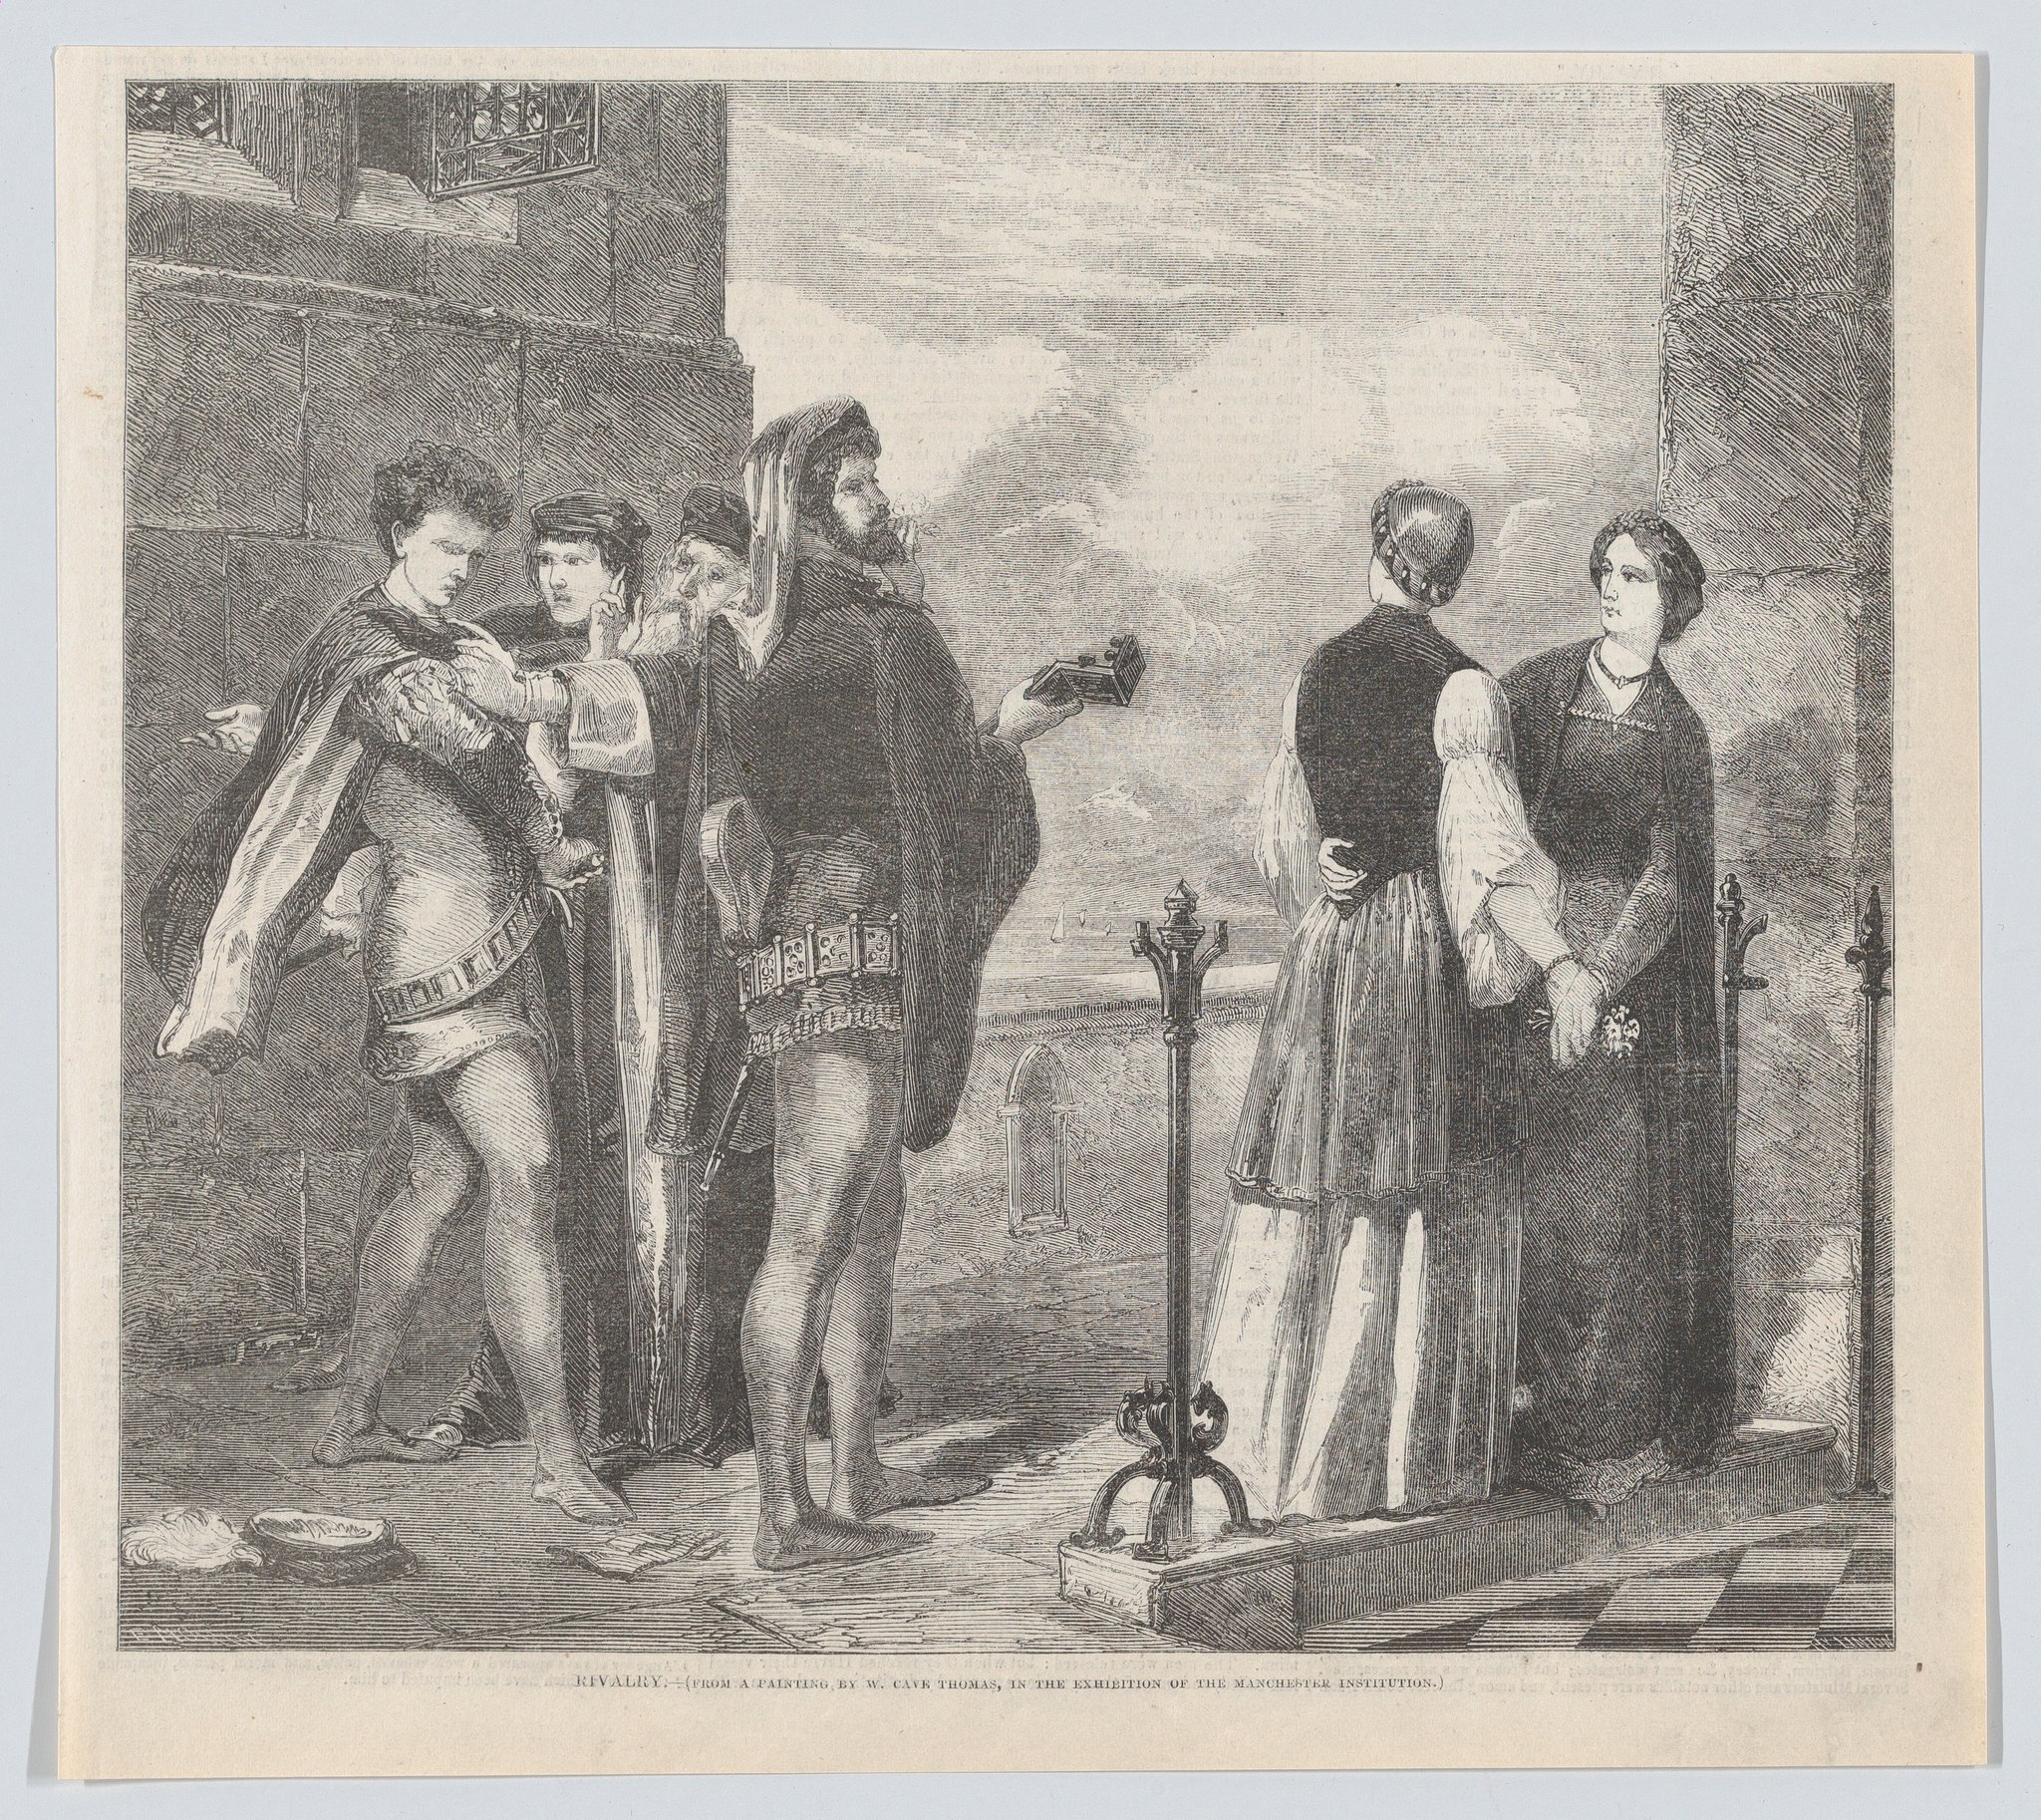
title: Rivalry, from "Illustrated Times"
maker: henry linton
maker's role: engraver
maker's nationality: british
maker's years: 1815-1899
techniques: engraving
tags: men,women